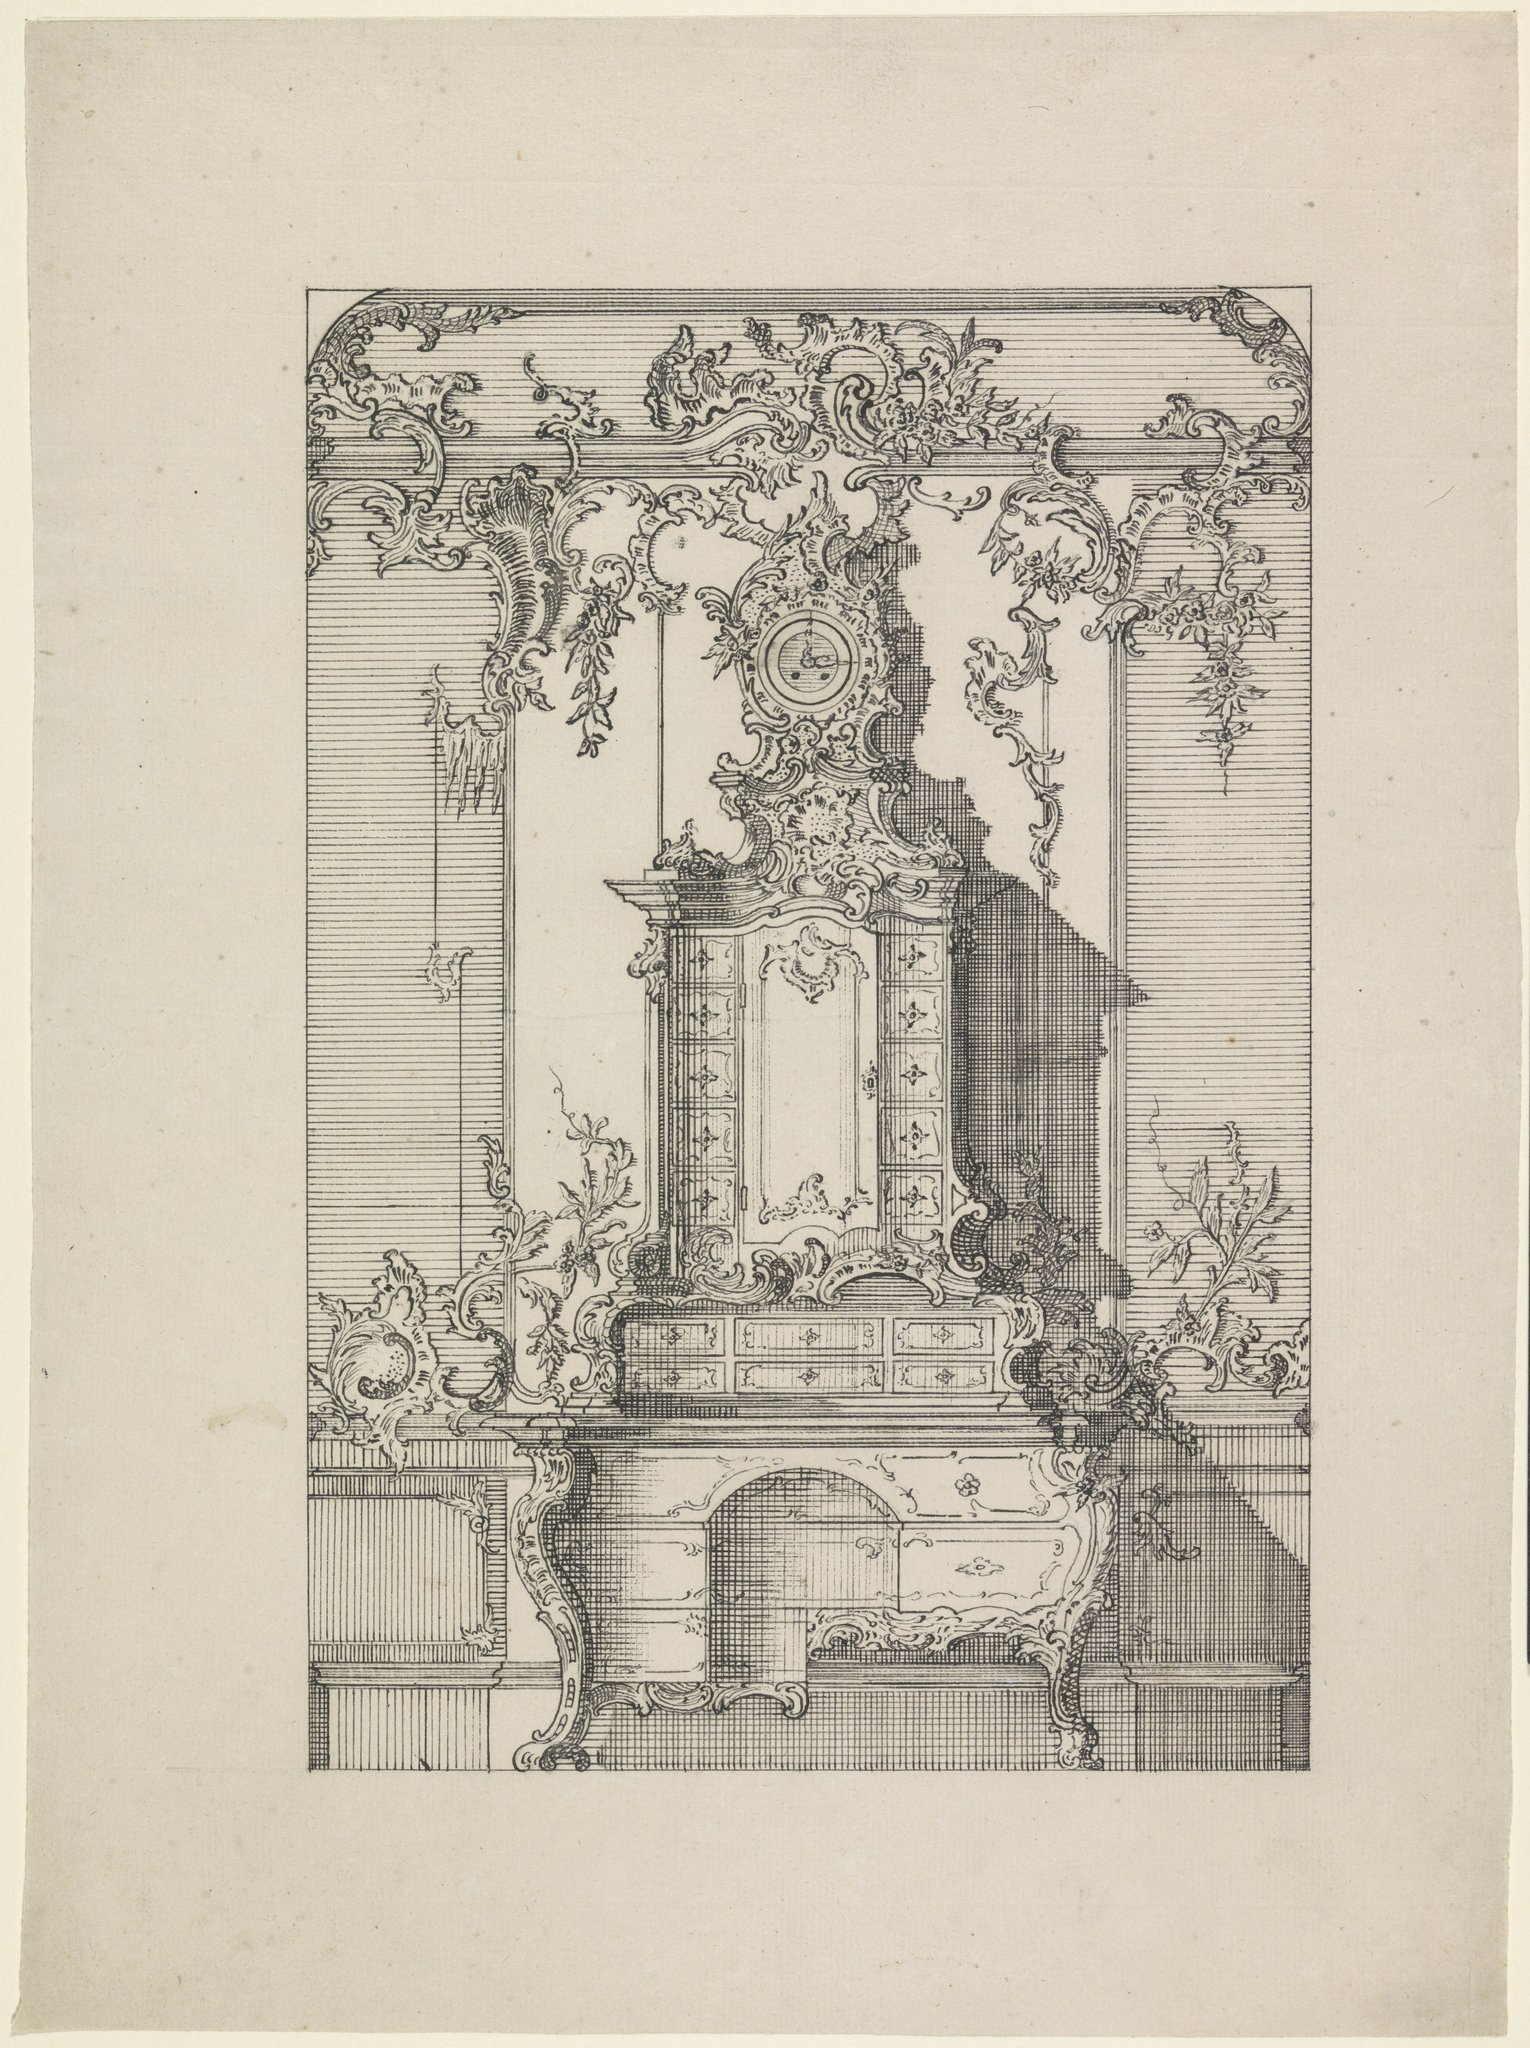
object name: drawing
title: Rocaille kast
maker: Anonymous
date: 1700-1800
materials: ink, paper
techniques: pen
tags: rocaille ornament, furniture for storage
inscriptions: collector's mark: Lugt 2228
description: Een geornamenteerde rocaille kast met lades, bekroond met een rocaille klok. Rondom de kast rocailles en bloemmotieven.